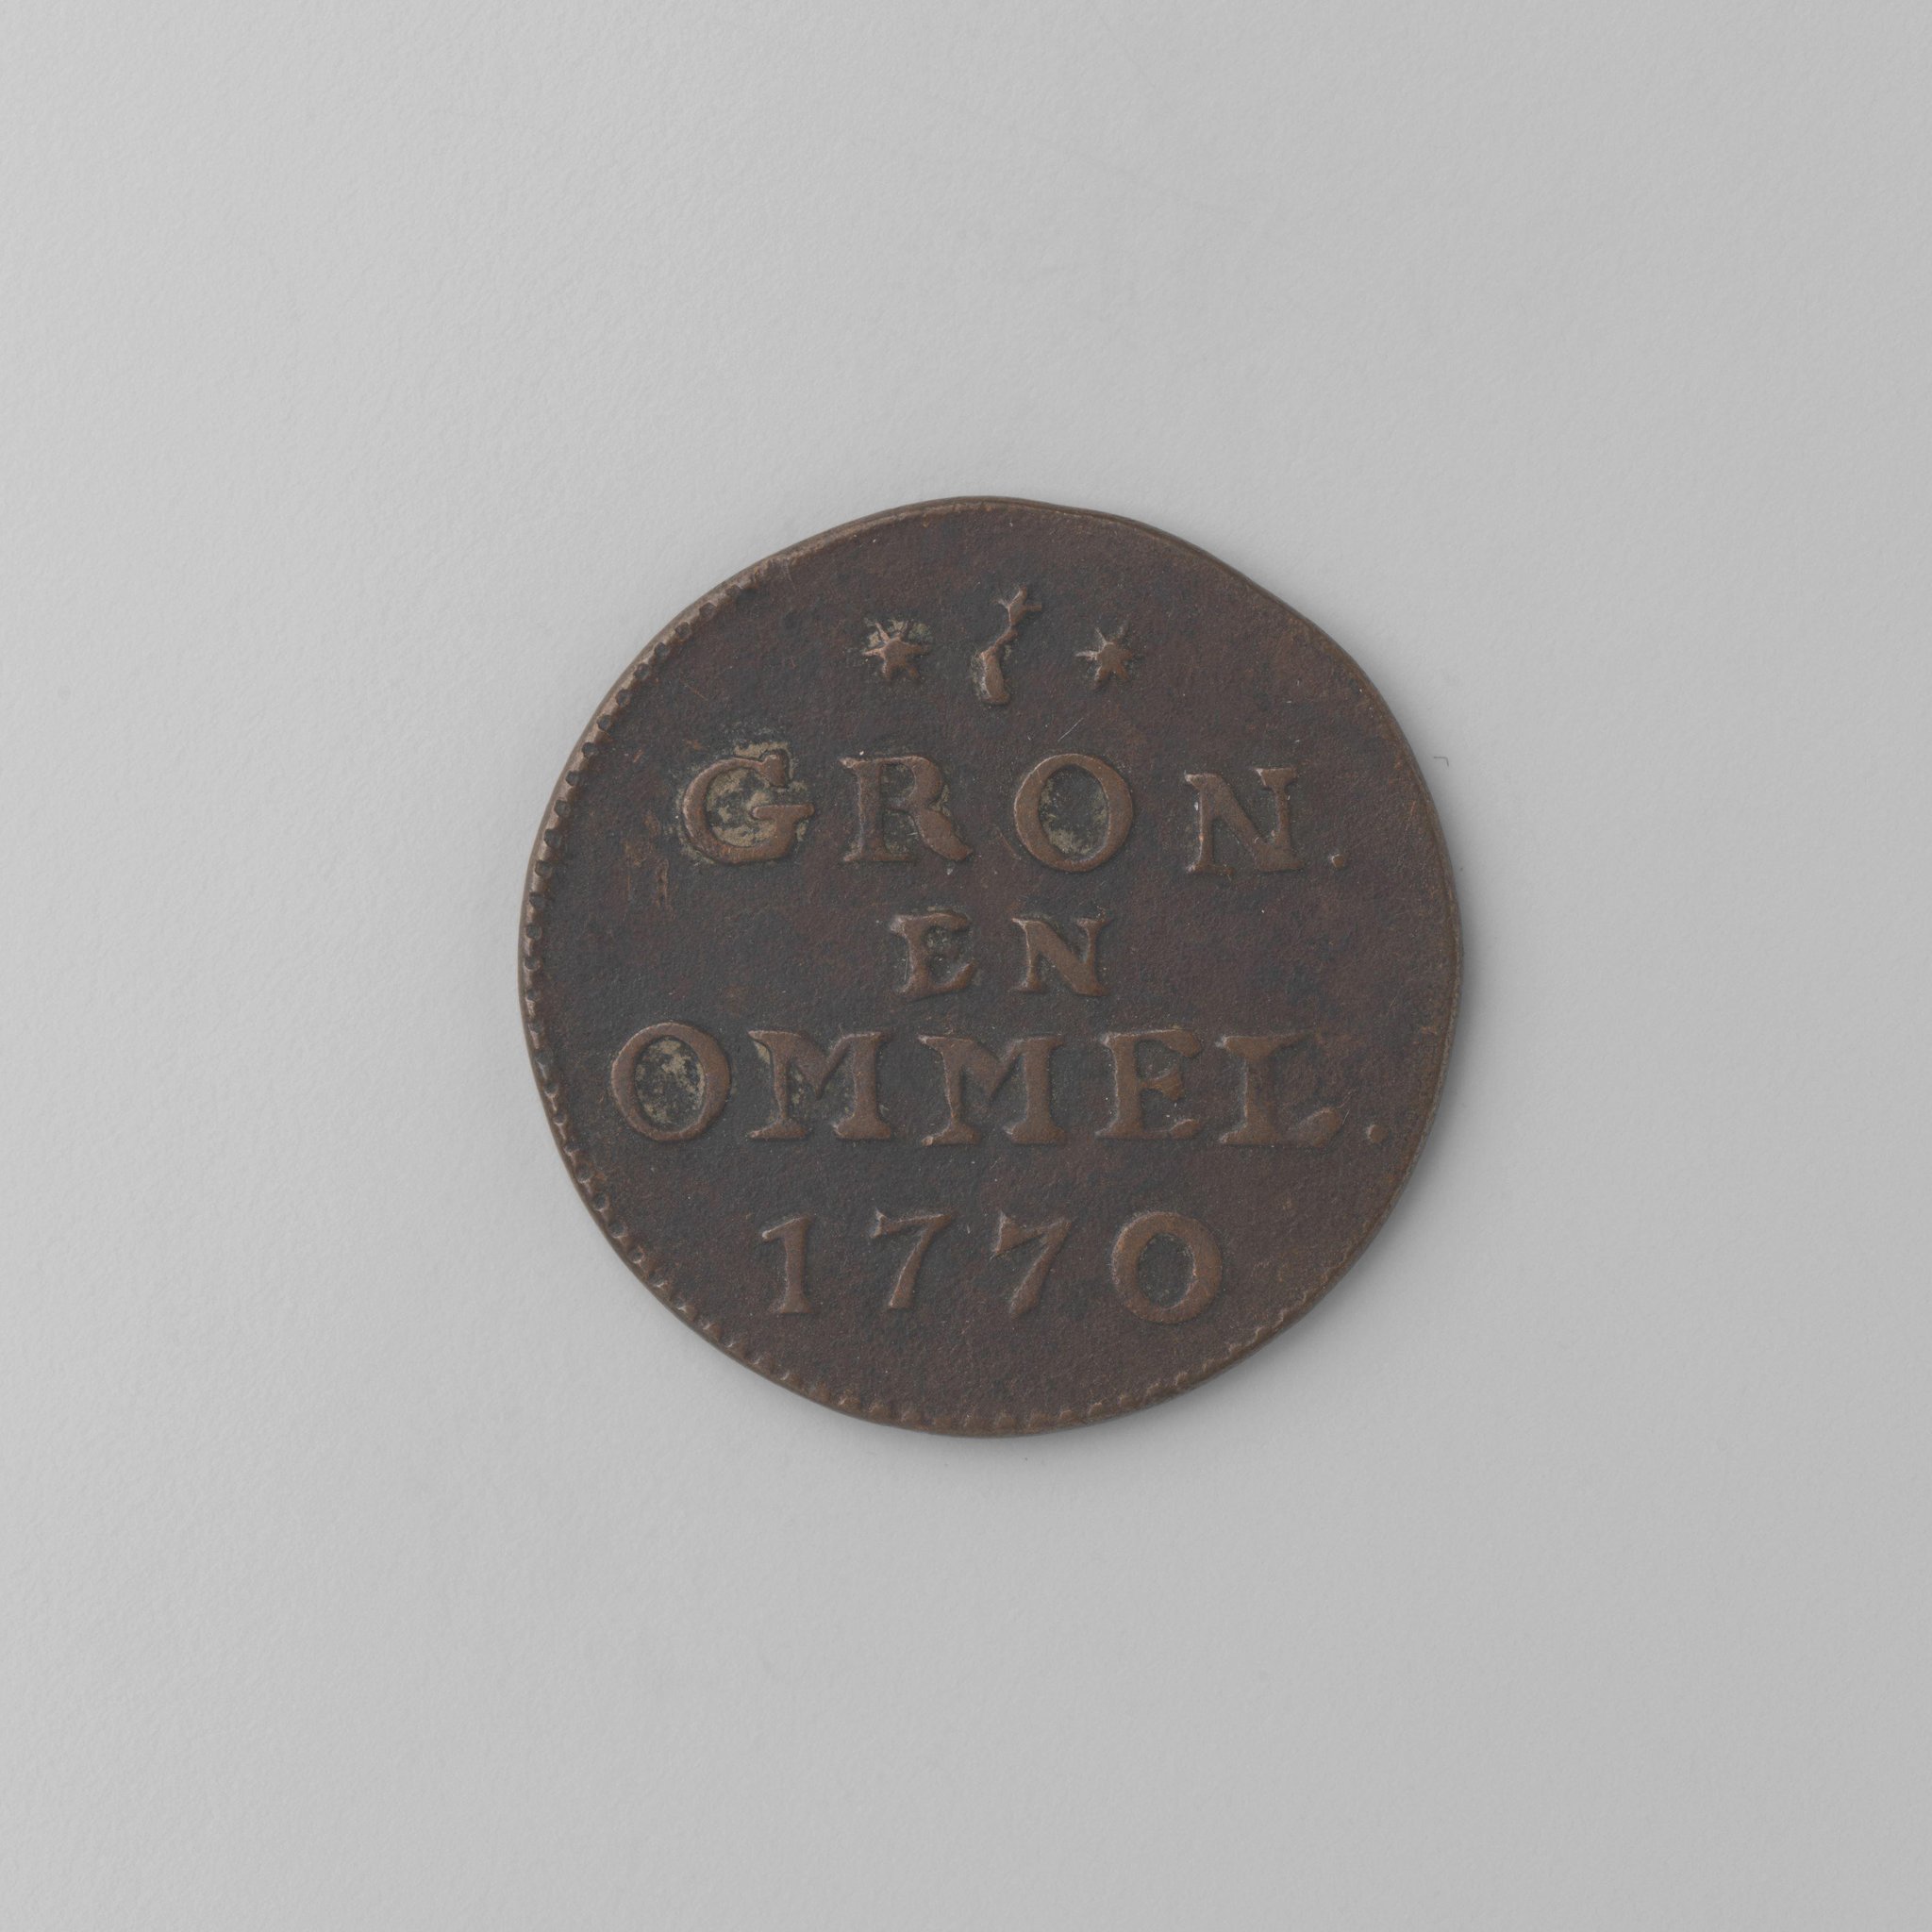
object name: coin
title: Duit van Groningen en de Ommelanden, 1770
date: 1770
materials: copper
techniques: striking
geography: harderwijk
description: Koperen munt. Voorzijde: binnen versiering gekroond wapenschild. Keerzijde: drie-regelig opschrift (in kleine letters), waarboven muntmeesterteken boompje van de muntmeester te Harderwijk en waaronder jaartal.